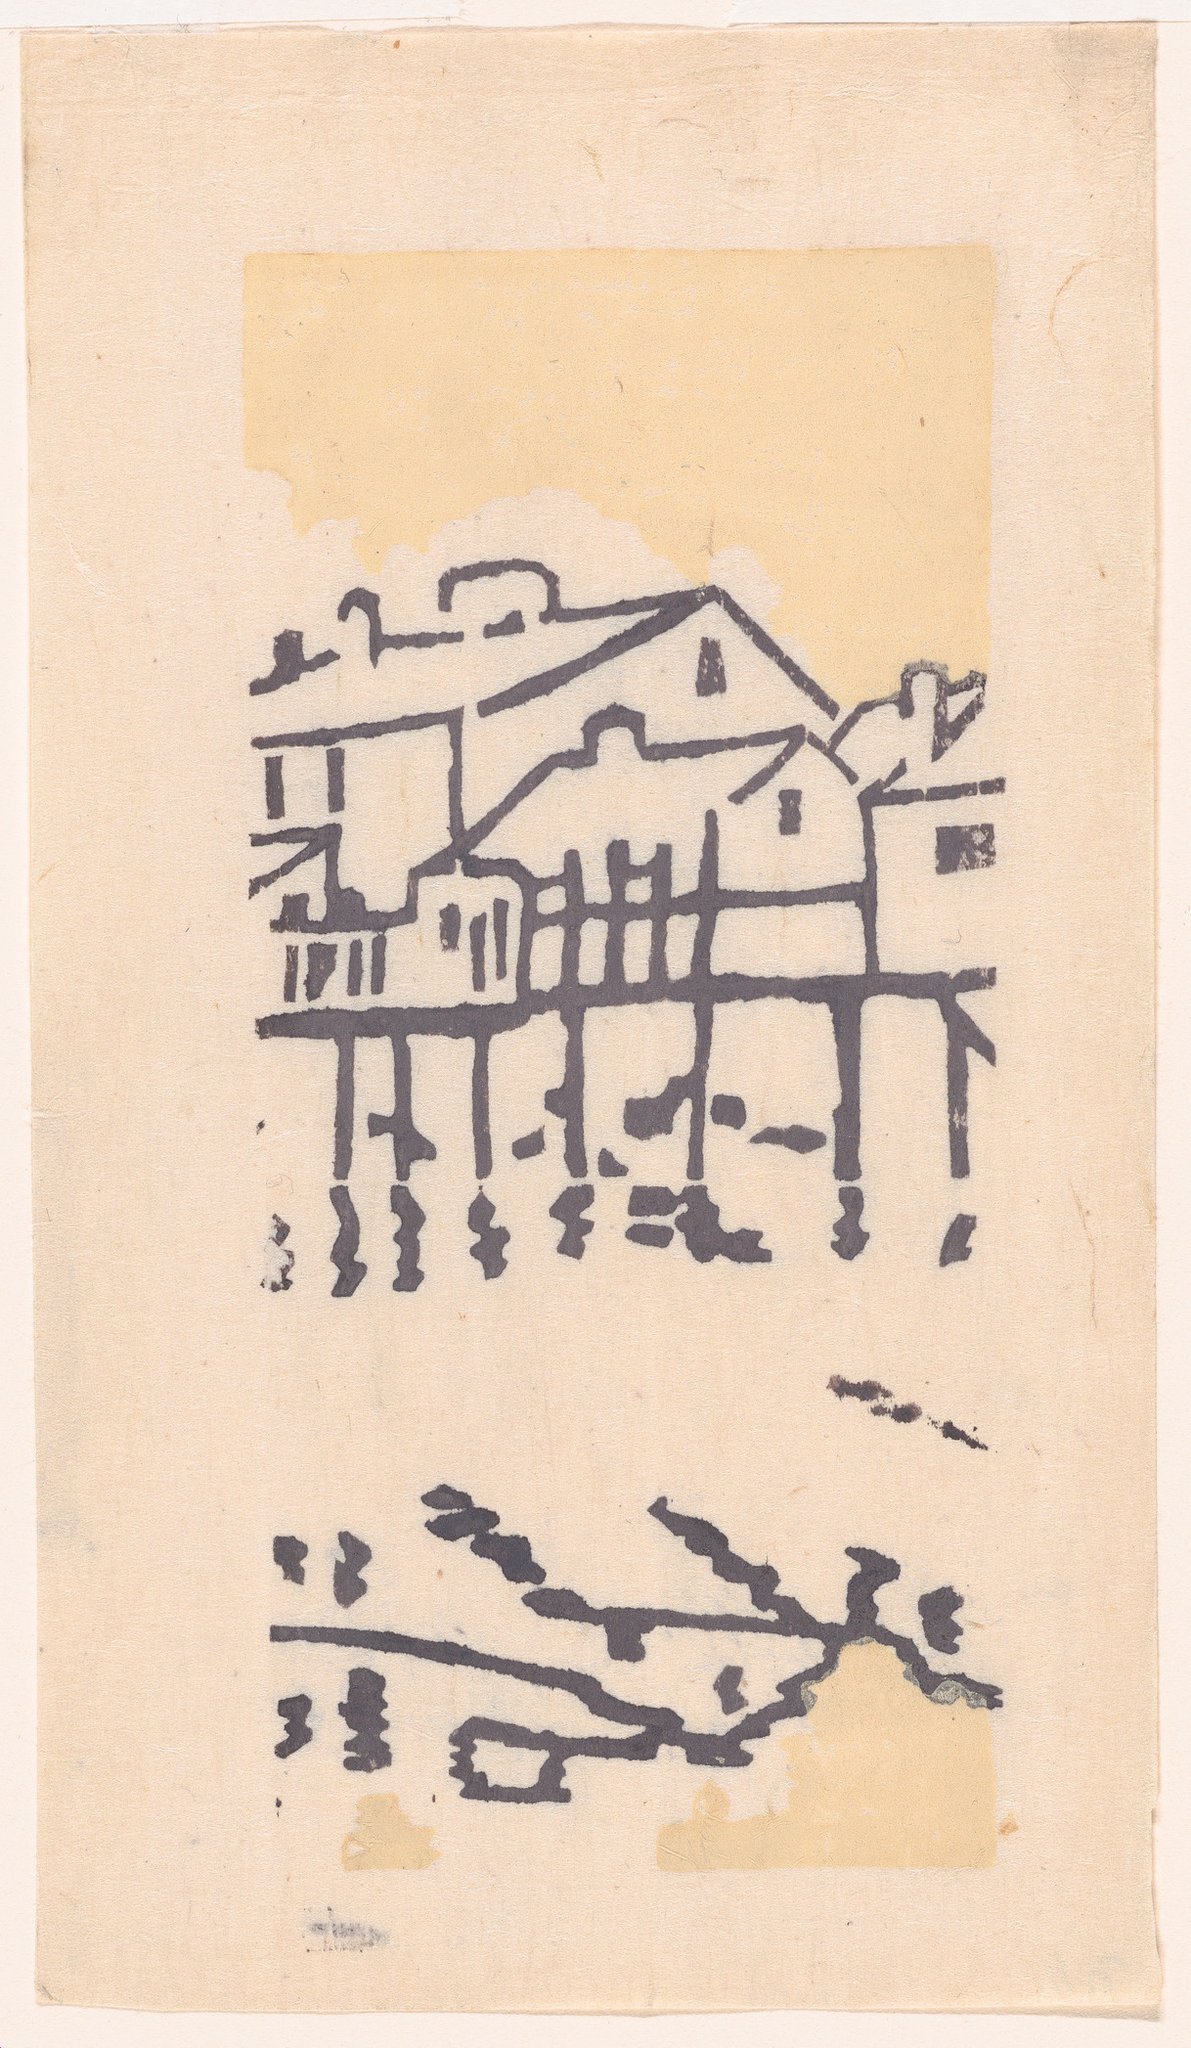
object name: print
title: Little Venice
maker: arthur wesley dow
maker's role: artist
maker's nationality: american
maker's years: 1857-1922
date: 1893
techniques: woodcut